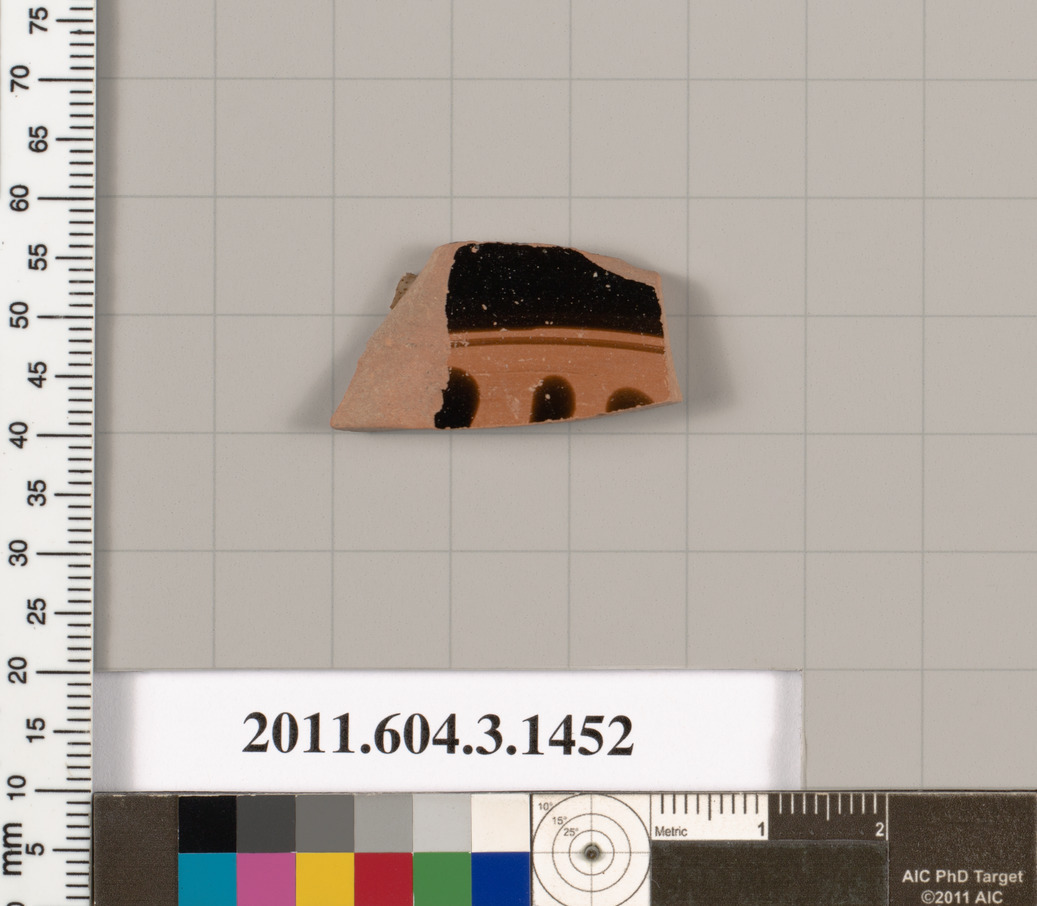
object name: skyphos fragment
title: Terracotta fragment of a skyphos (deep drinking cup)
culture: greek, attic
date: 534-468 BCE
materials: terracotta